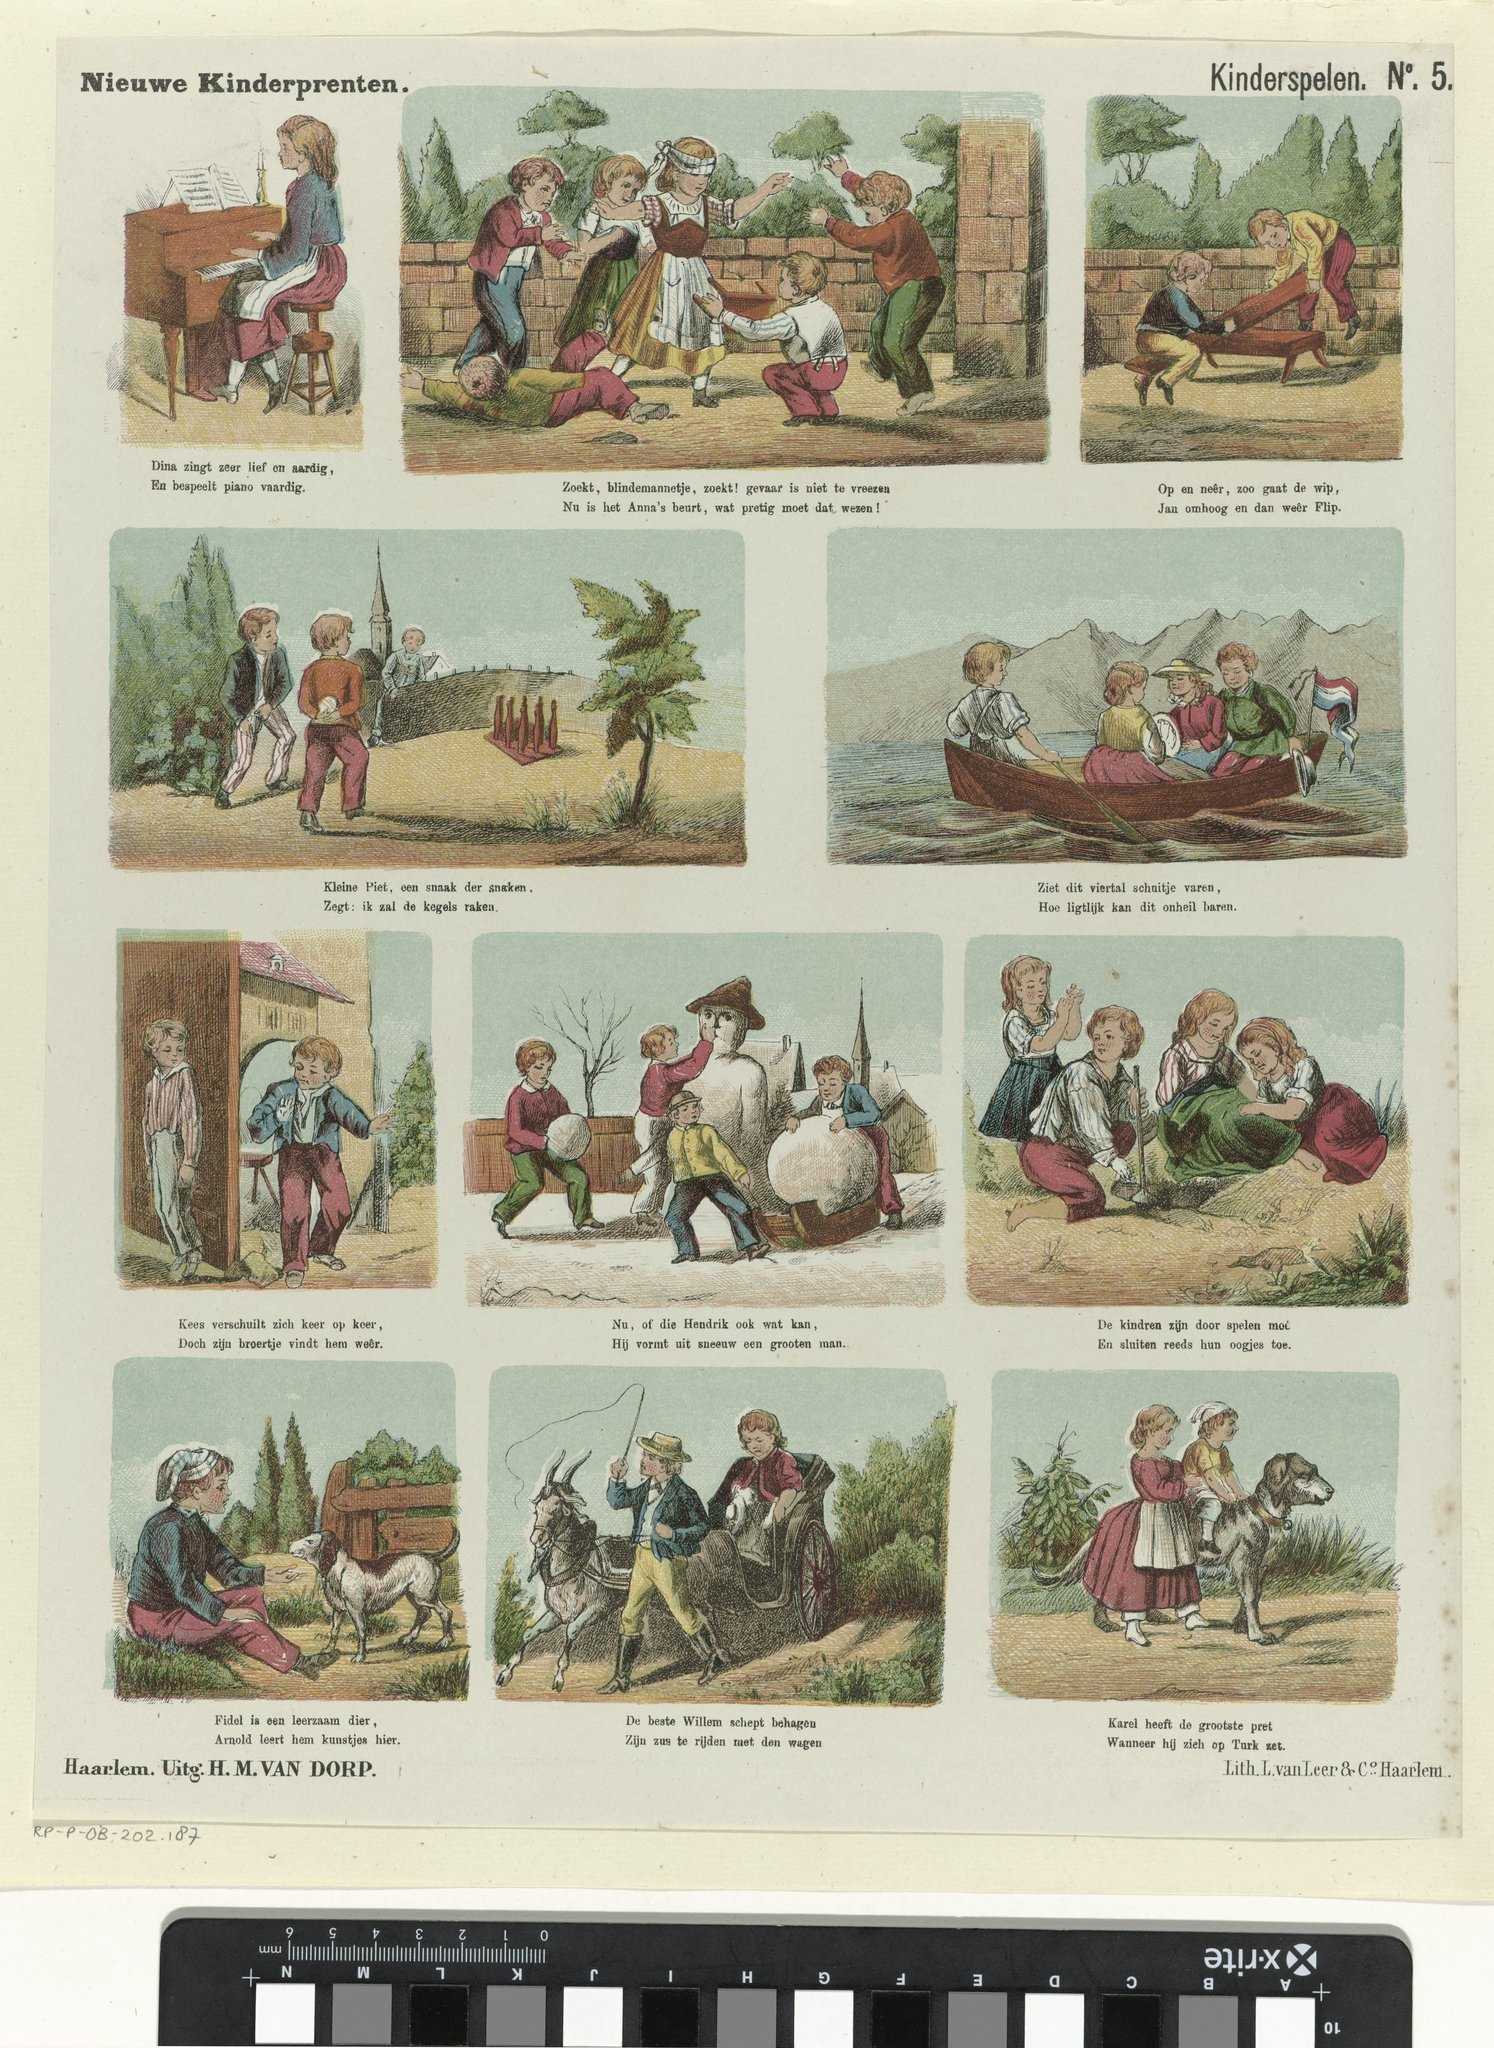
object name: popular print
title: Kinderspelen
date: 1872-1883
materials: paper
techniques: lithograph, letterpress printing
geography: haarlem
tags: children's games and plays, blind-man's buff, bowling games (children's games), seesaw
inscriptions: collector's mark: Lugt 2760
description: Blad met 11 voorstellingen van kinderspelen, waaronder blindemannetje, wippen, kegelen, bootje varen, verstoppertje en spelen met de hond. Onder elke voorstelling een tweeregelig vers. Genummerd rechtsboven: No. 5.